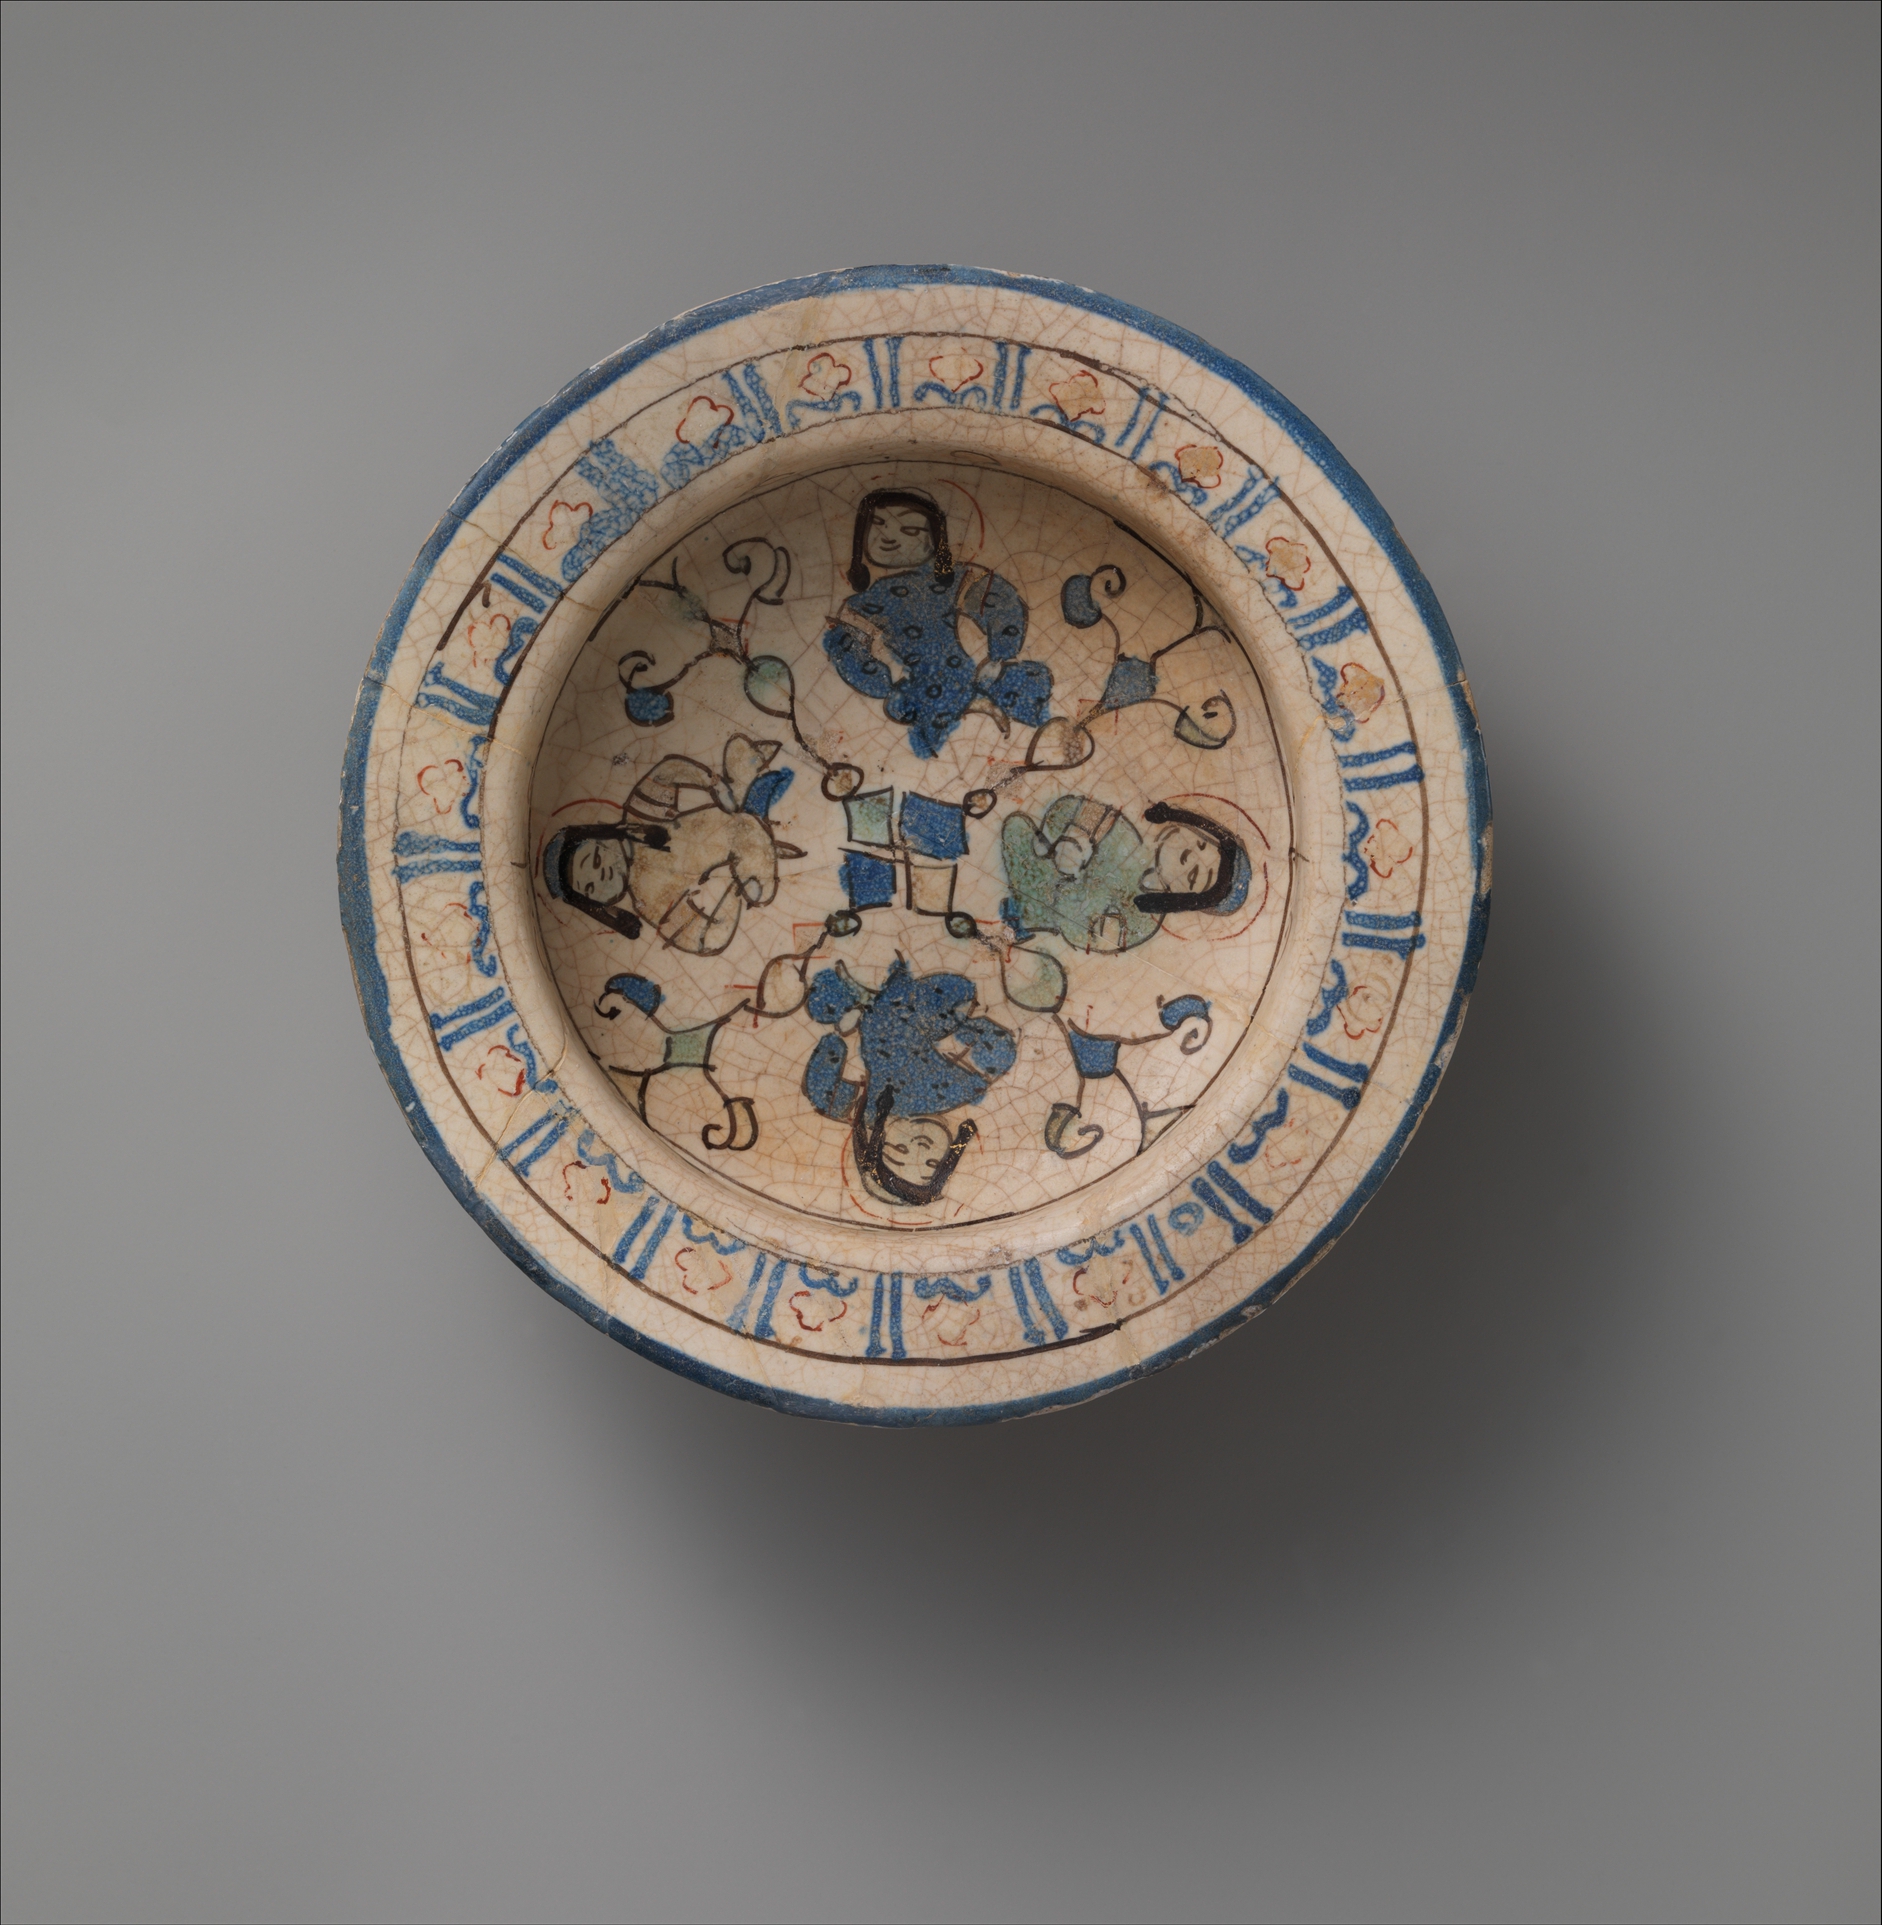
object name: footed bowl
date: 1101-1300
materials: stonepaste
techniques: overglaze, painting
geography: iran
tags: human figures